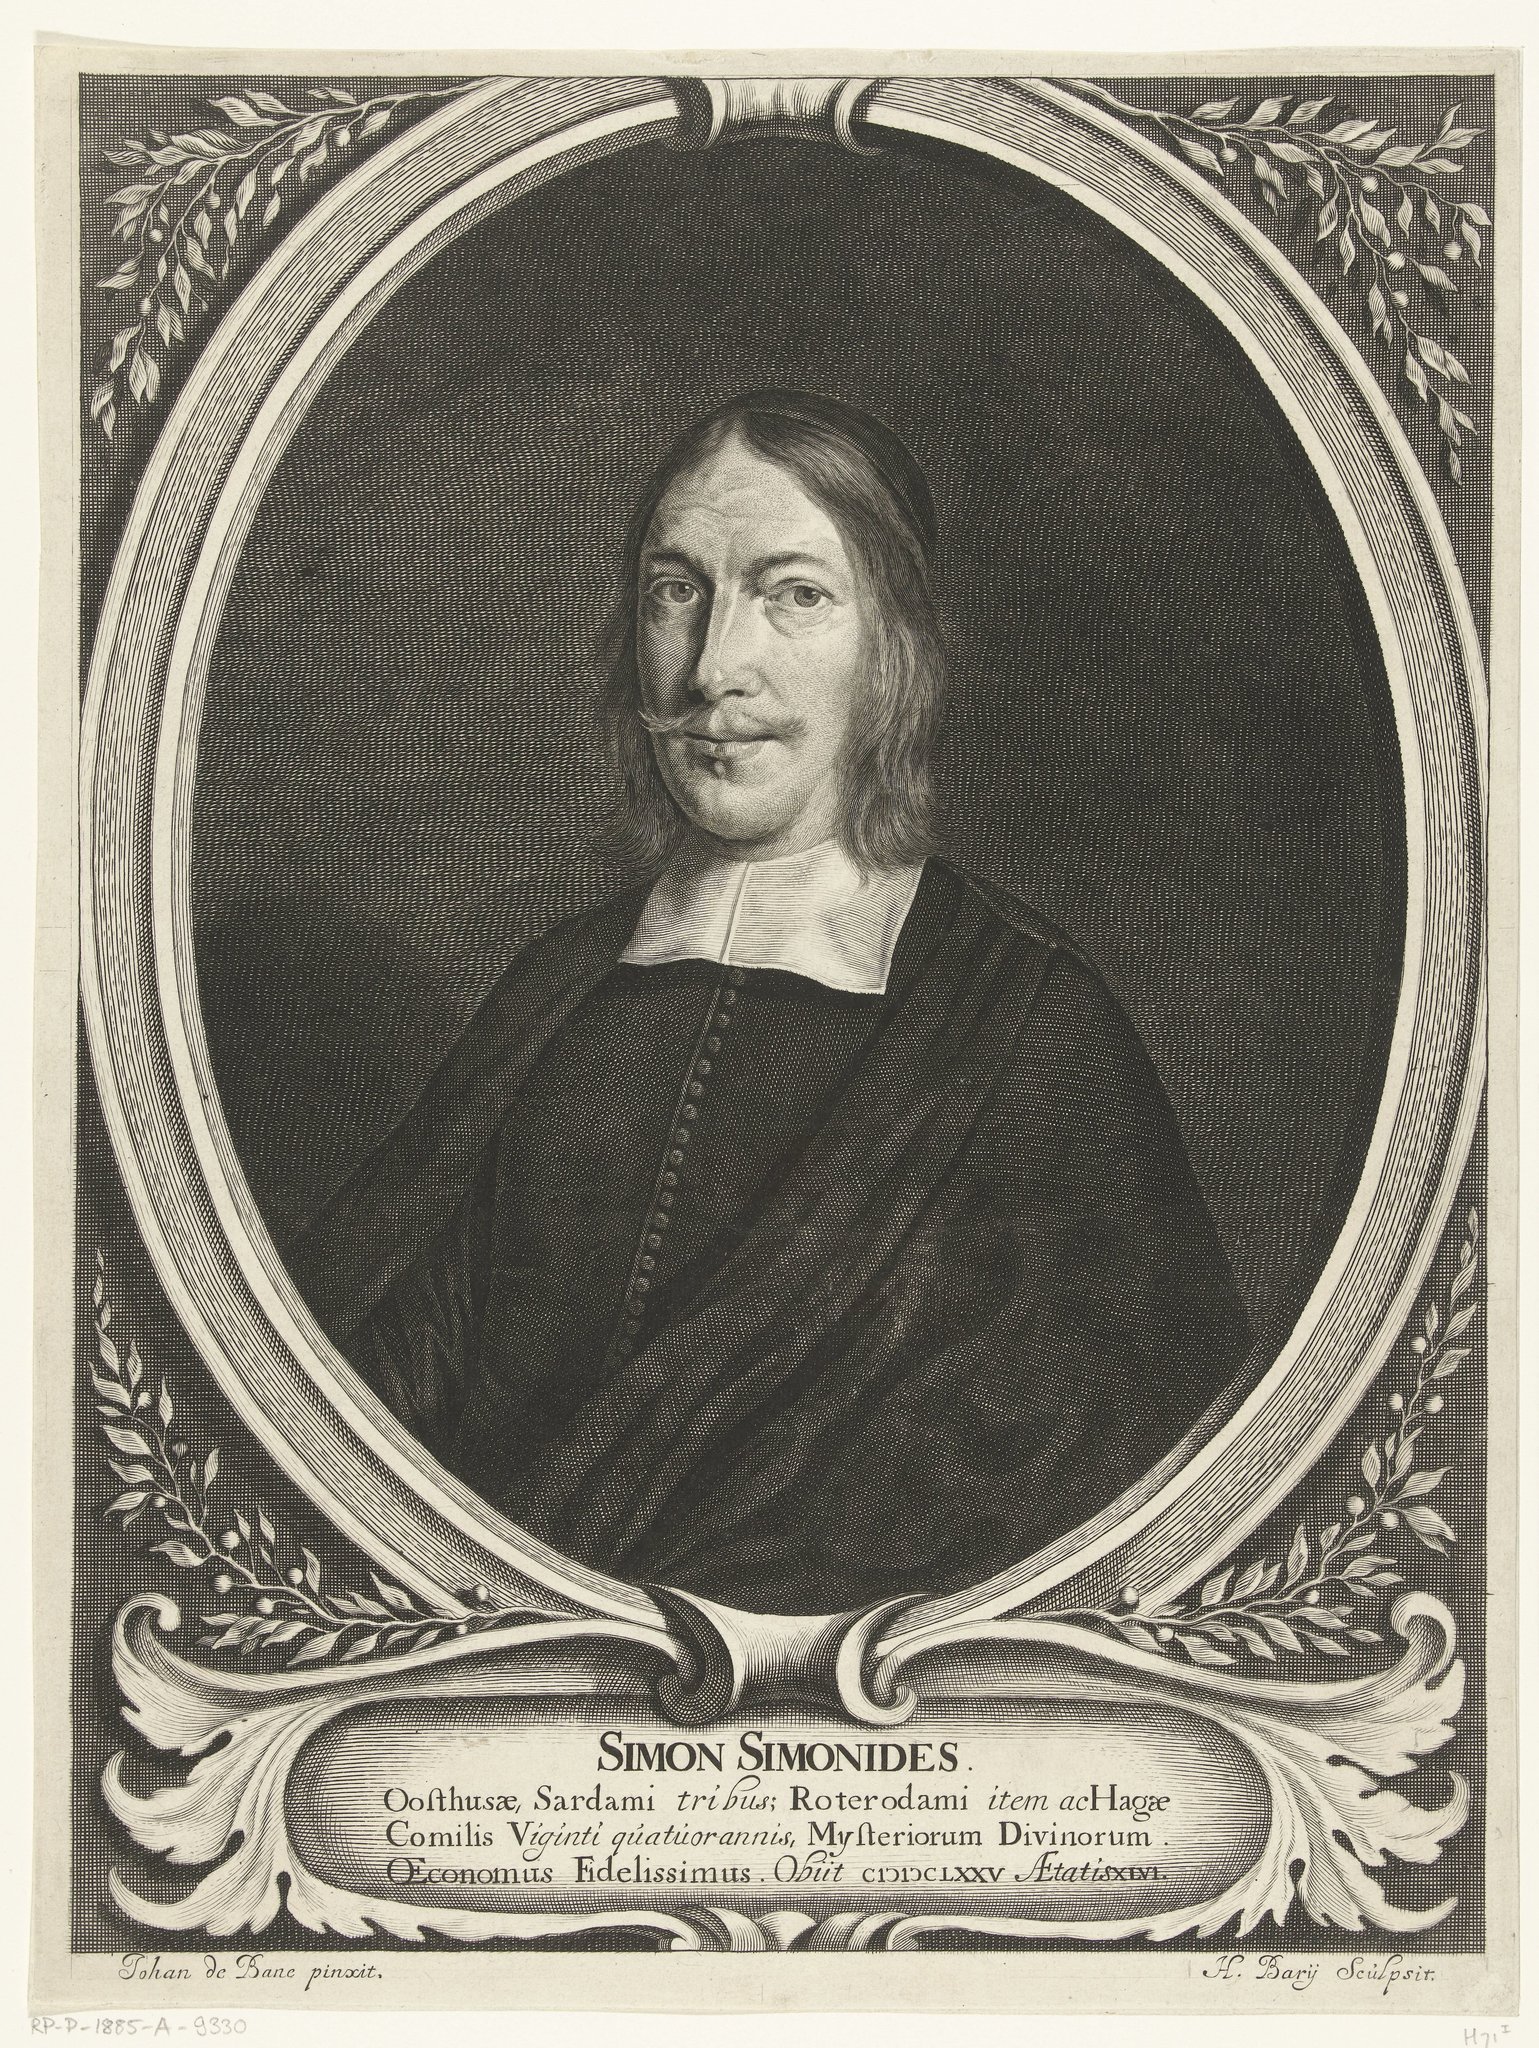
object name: print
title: Portret van Simon Simonides op 46-jarige leeftijd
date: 1657-1707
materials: paper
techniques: engraving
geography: netherlands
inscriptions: collector's mark: Lugt 2228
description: Portret van Simon Simonides, onder het portret zijn naam, leefjaren en functies.